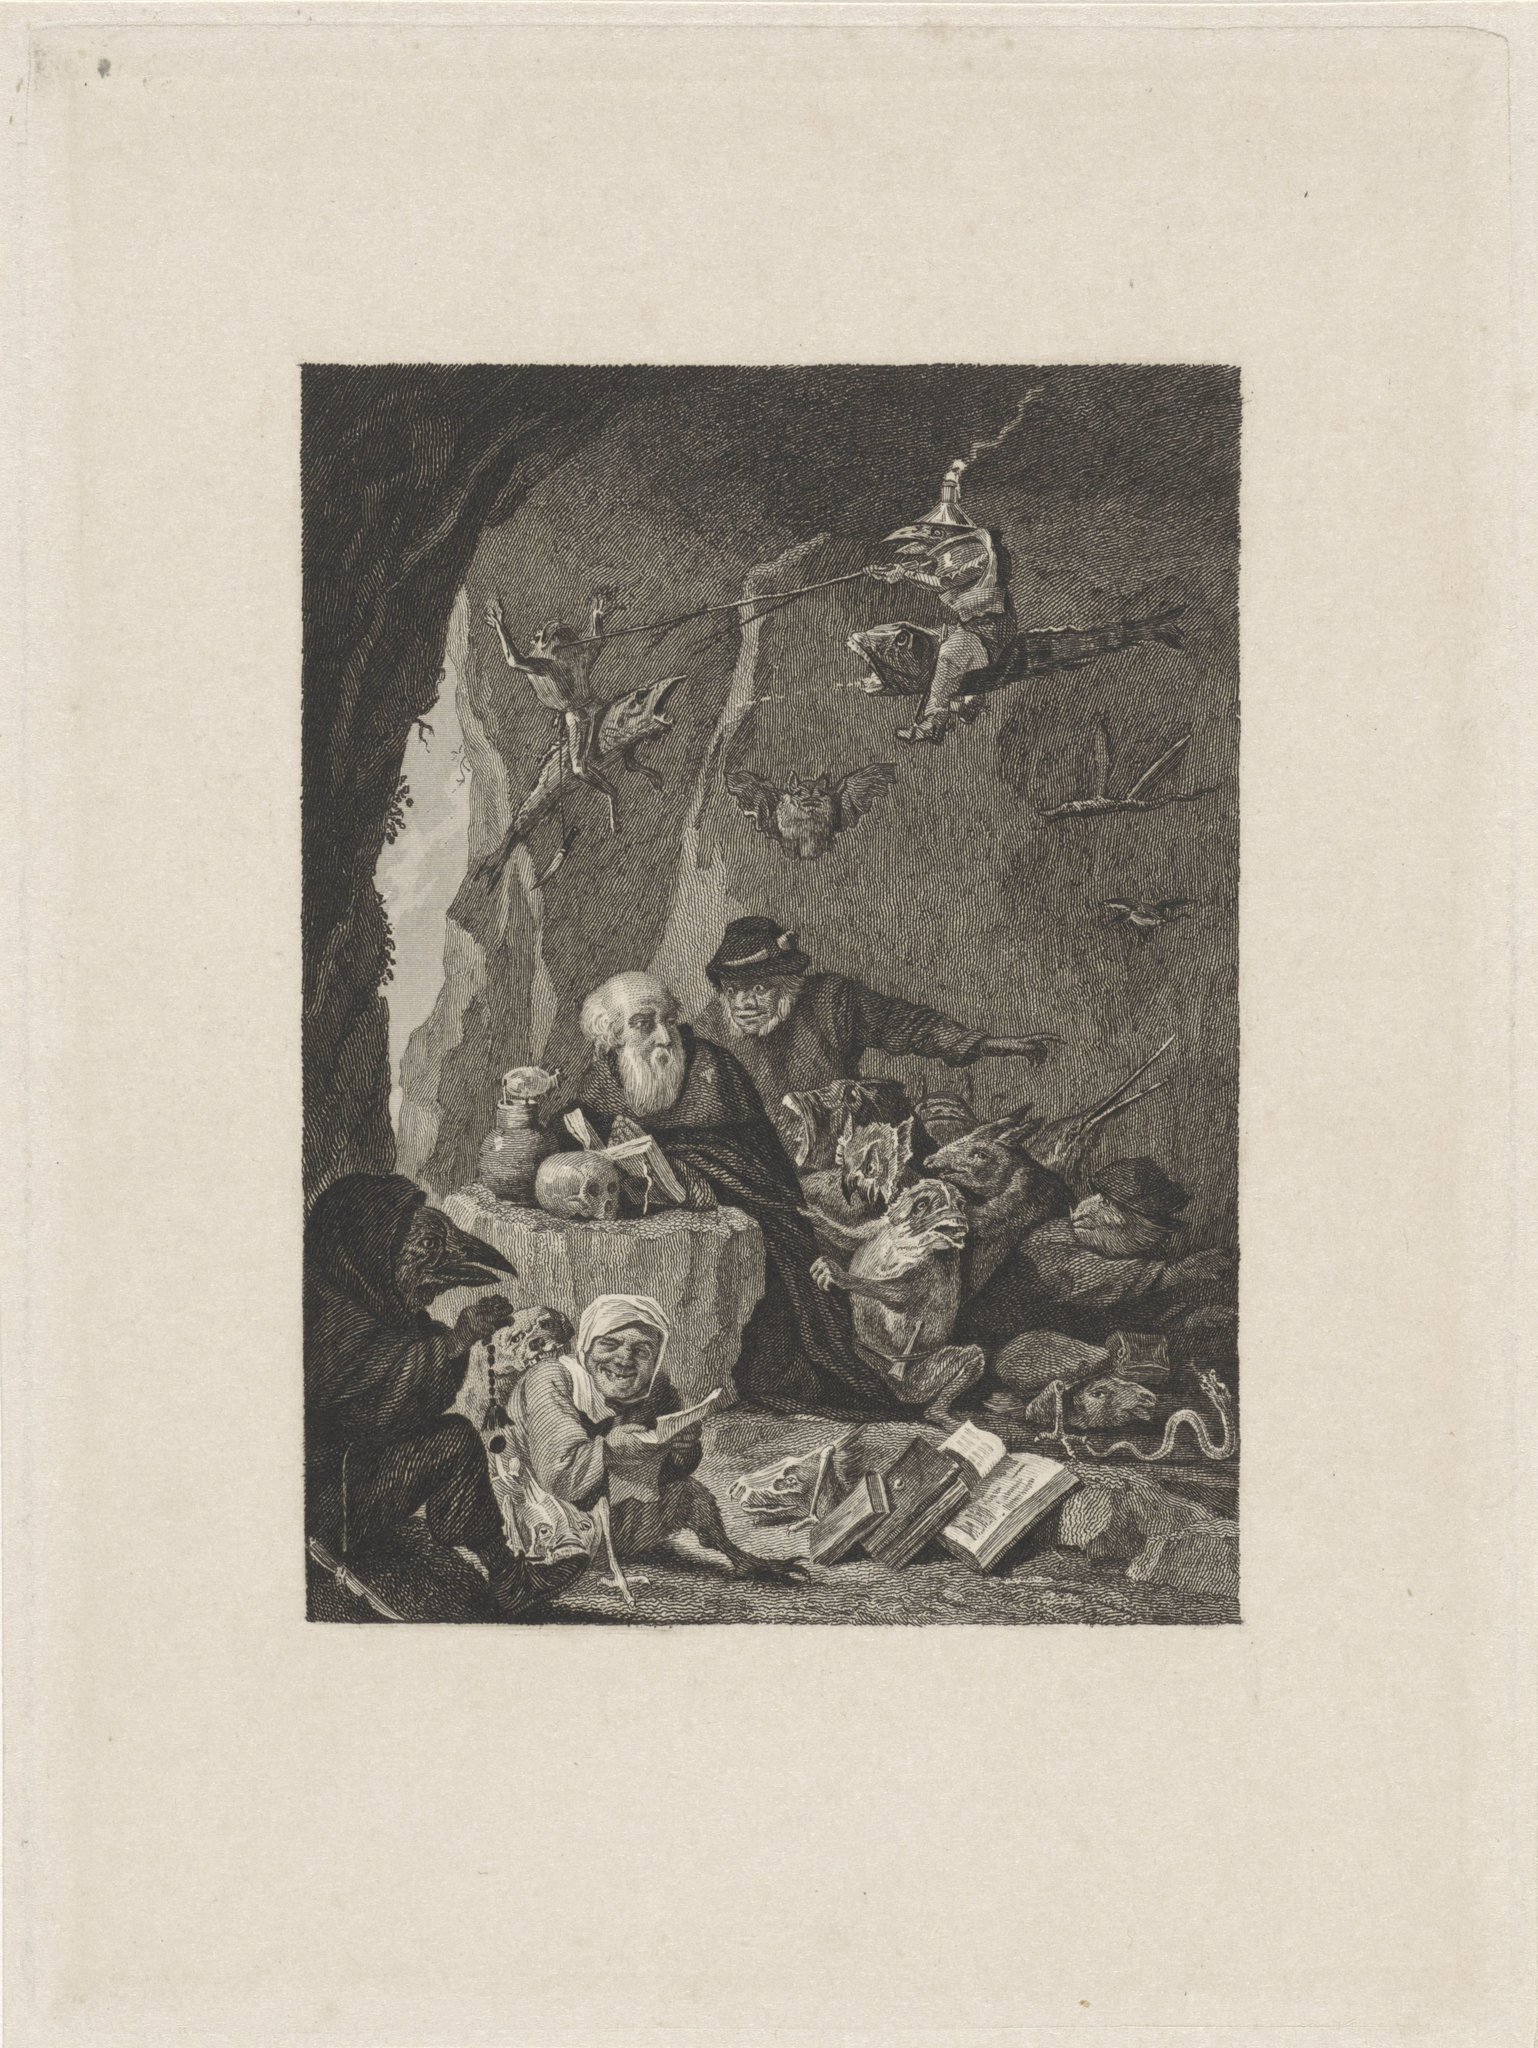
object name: print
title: De verzoeking van de H. Antonius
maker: dirk jurriaan sluyter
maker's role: draughtsman, print maker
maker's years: 1811-1886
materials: paper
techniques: engraving, etching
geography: amsterdam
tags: devil(s) and demons, book - mm - book open, book, st. antony abbot tormented by devils, attacking him on the ground or carrying him aloft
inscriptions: collector's mark: Lugt 2228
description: De H. Antonius zit geknield te bidden in een grot. Op een rotsblok voor hem liggen een boek en een schedel. Om hem heen vliegen, lopen en zitten demonen in de vorm van wonderlijk gevormde dieren of mensen met dierenledematen. Op de grond liggen boeken.